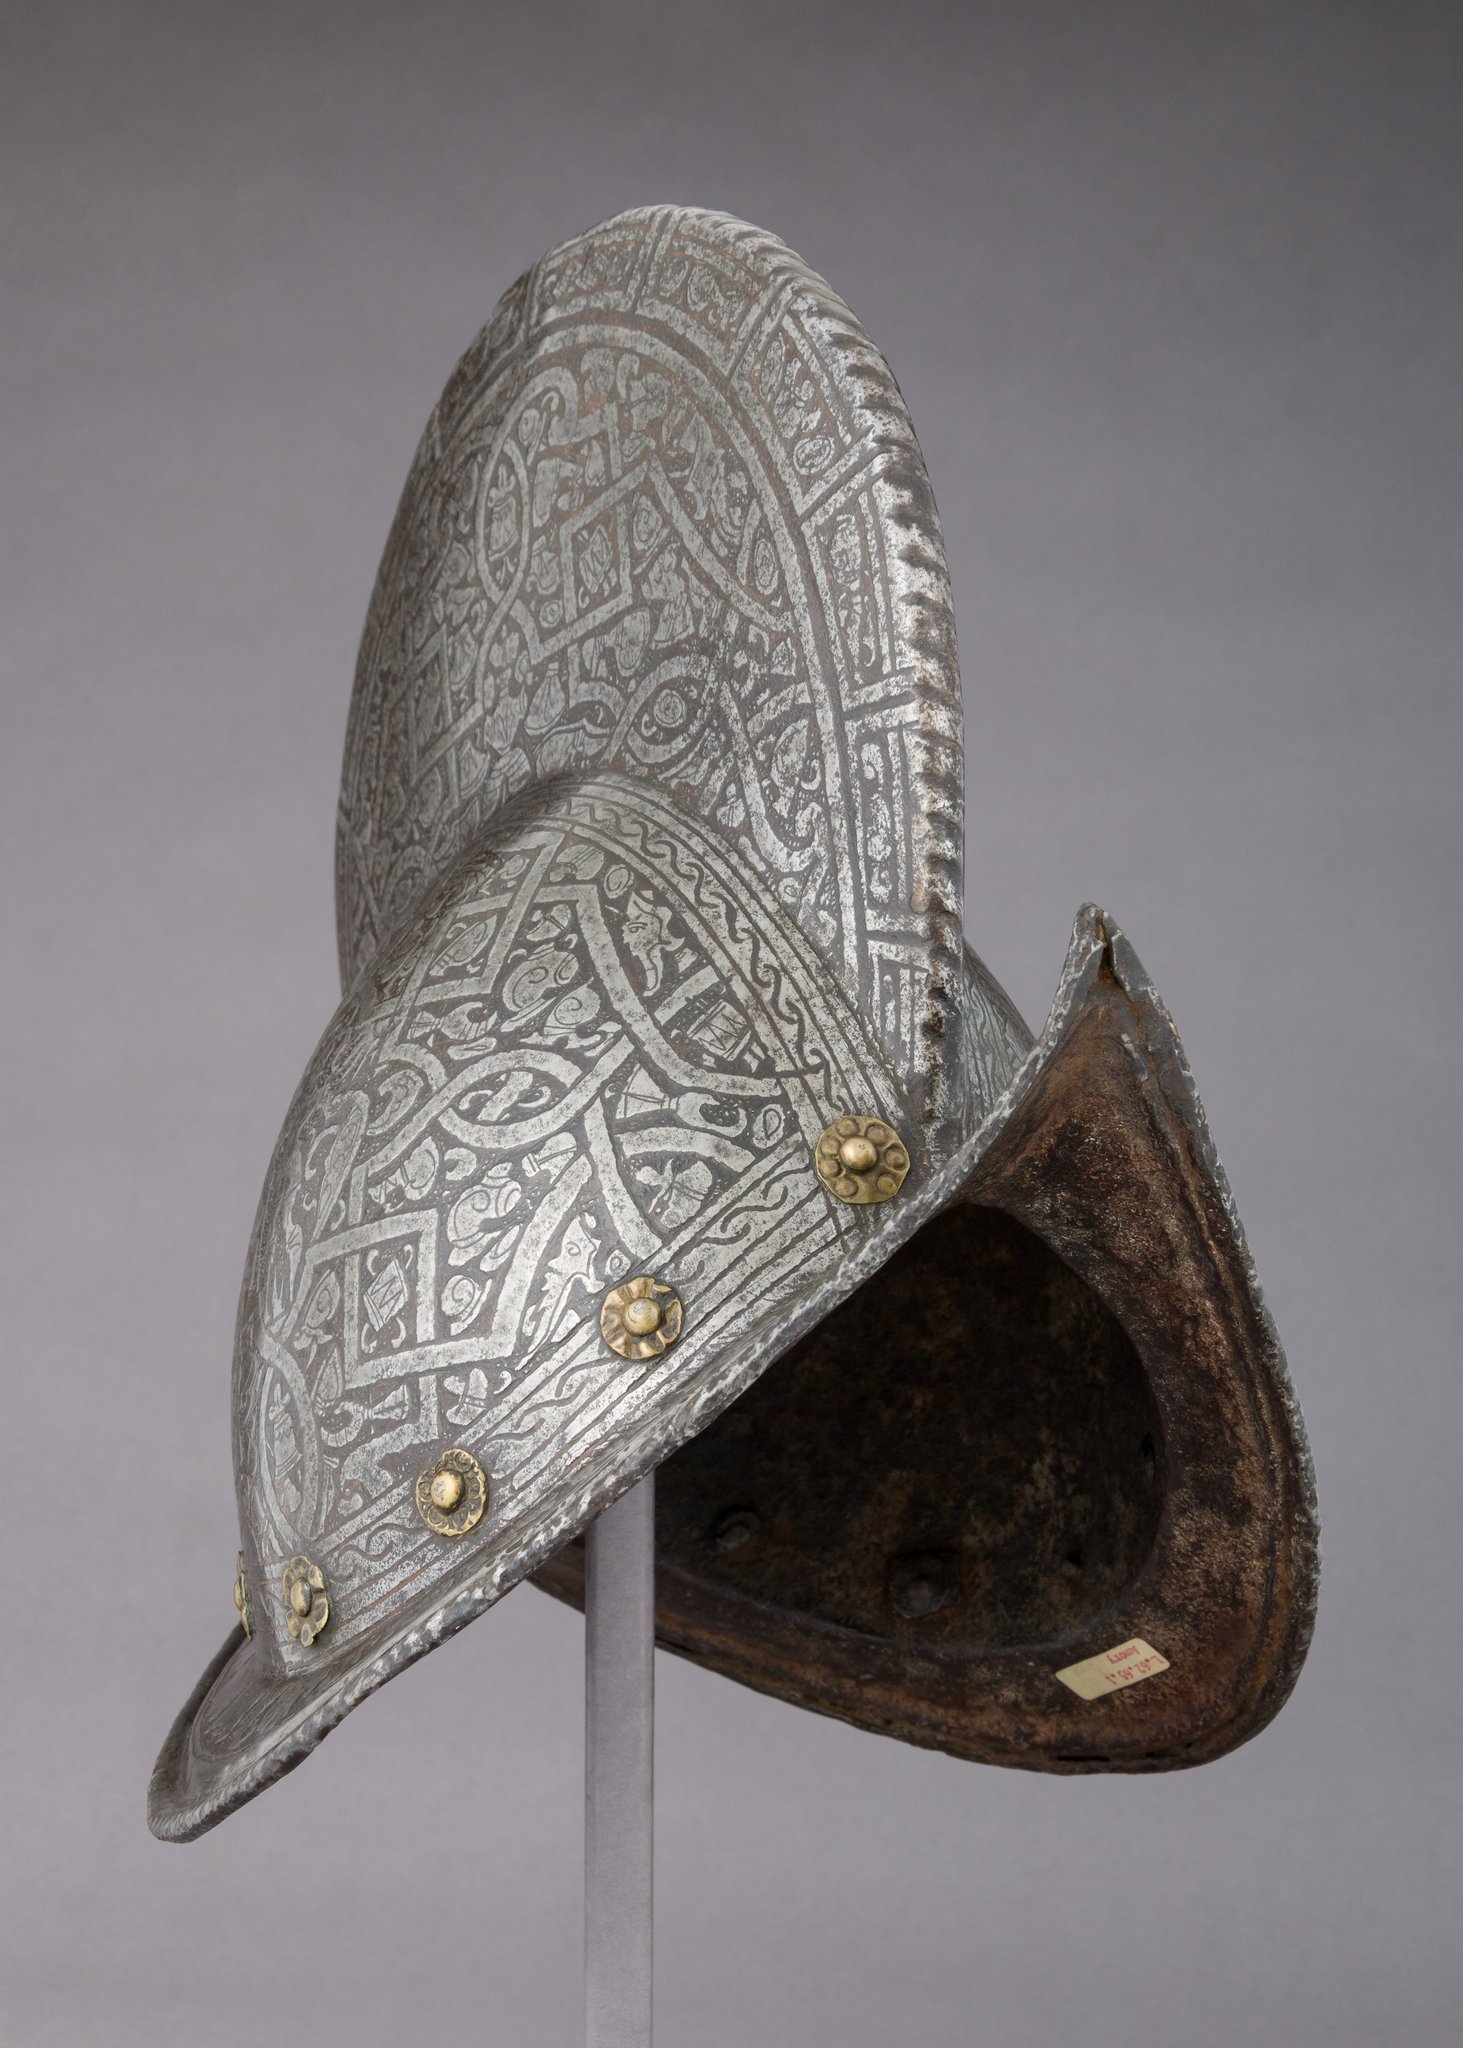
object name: morion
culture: italian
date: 1575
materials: brass, steel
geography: italy